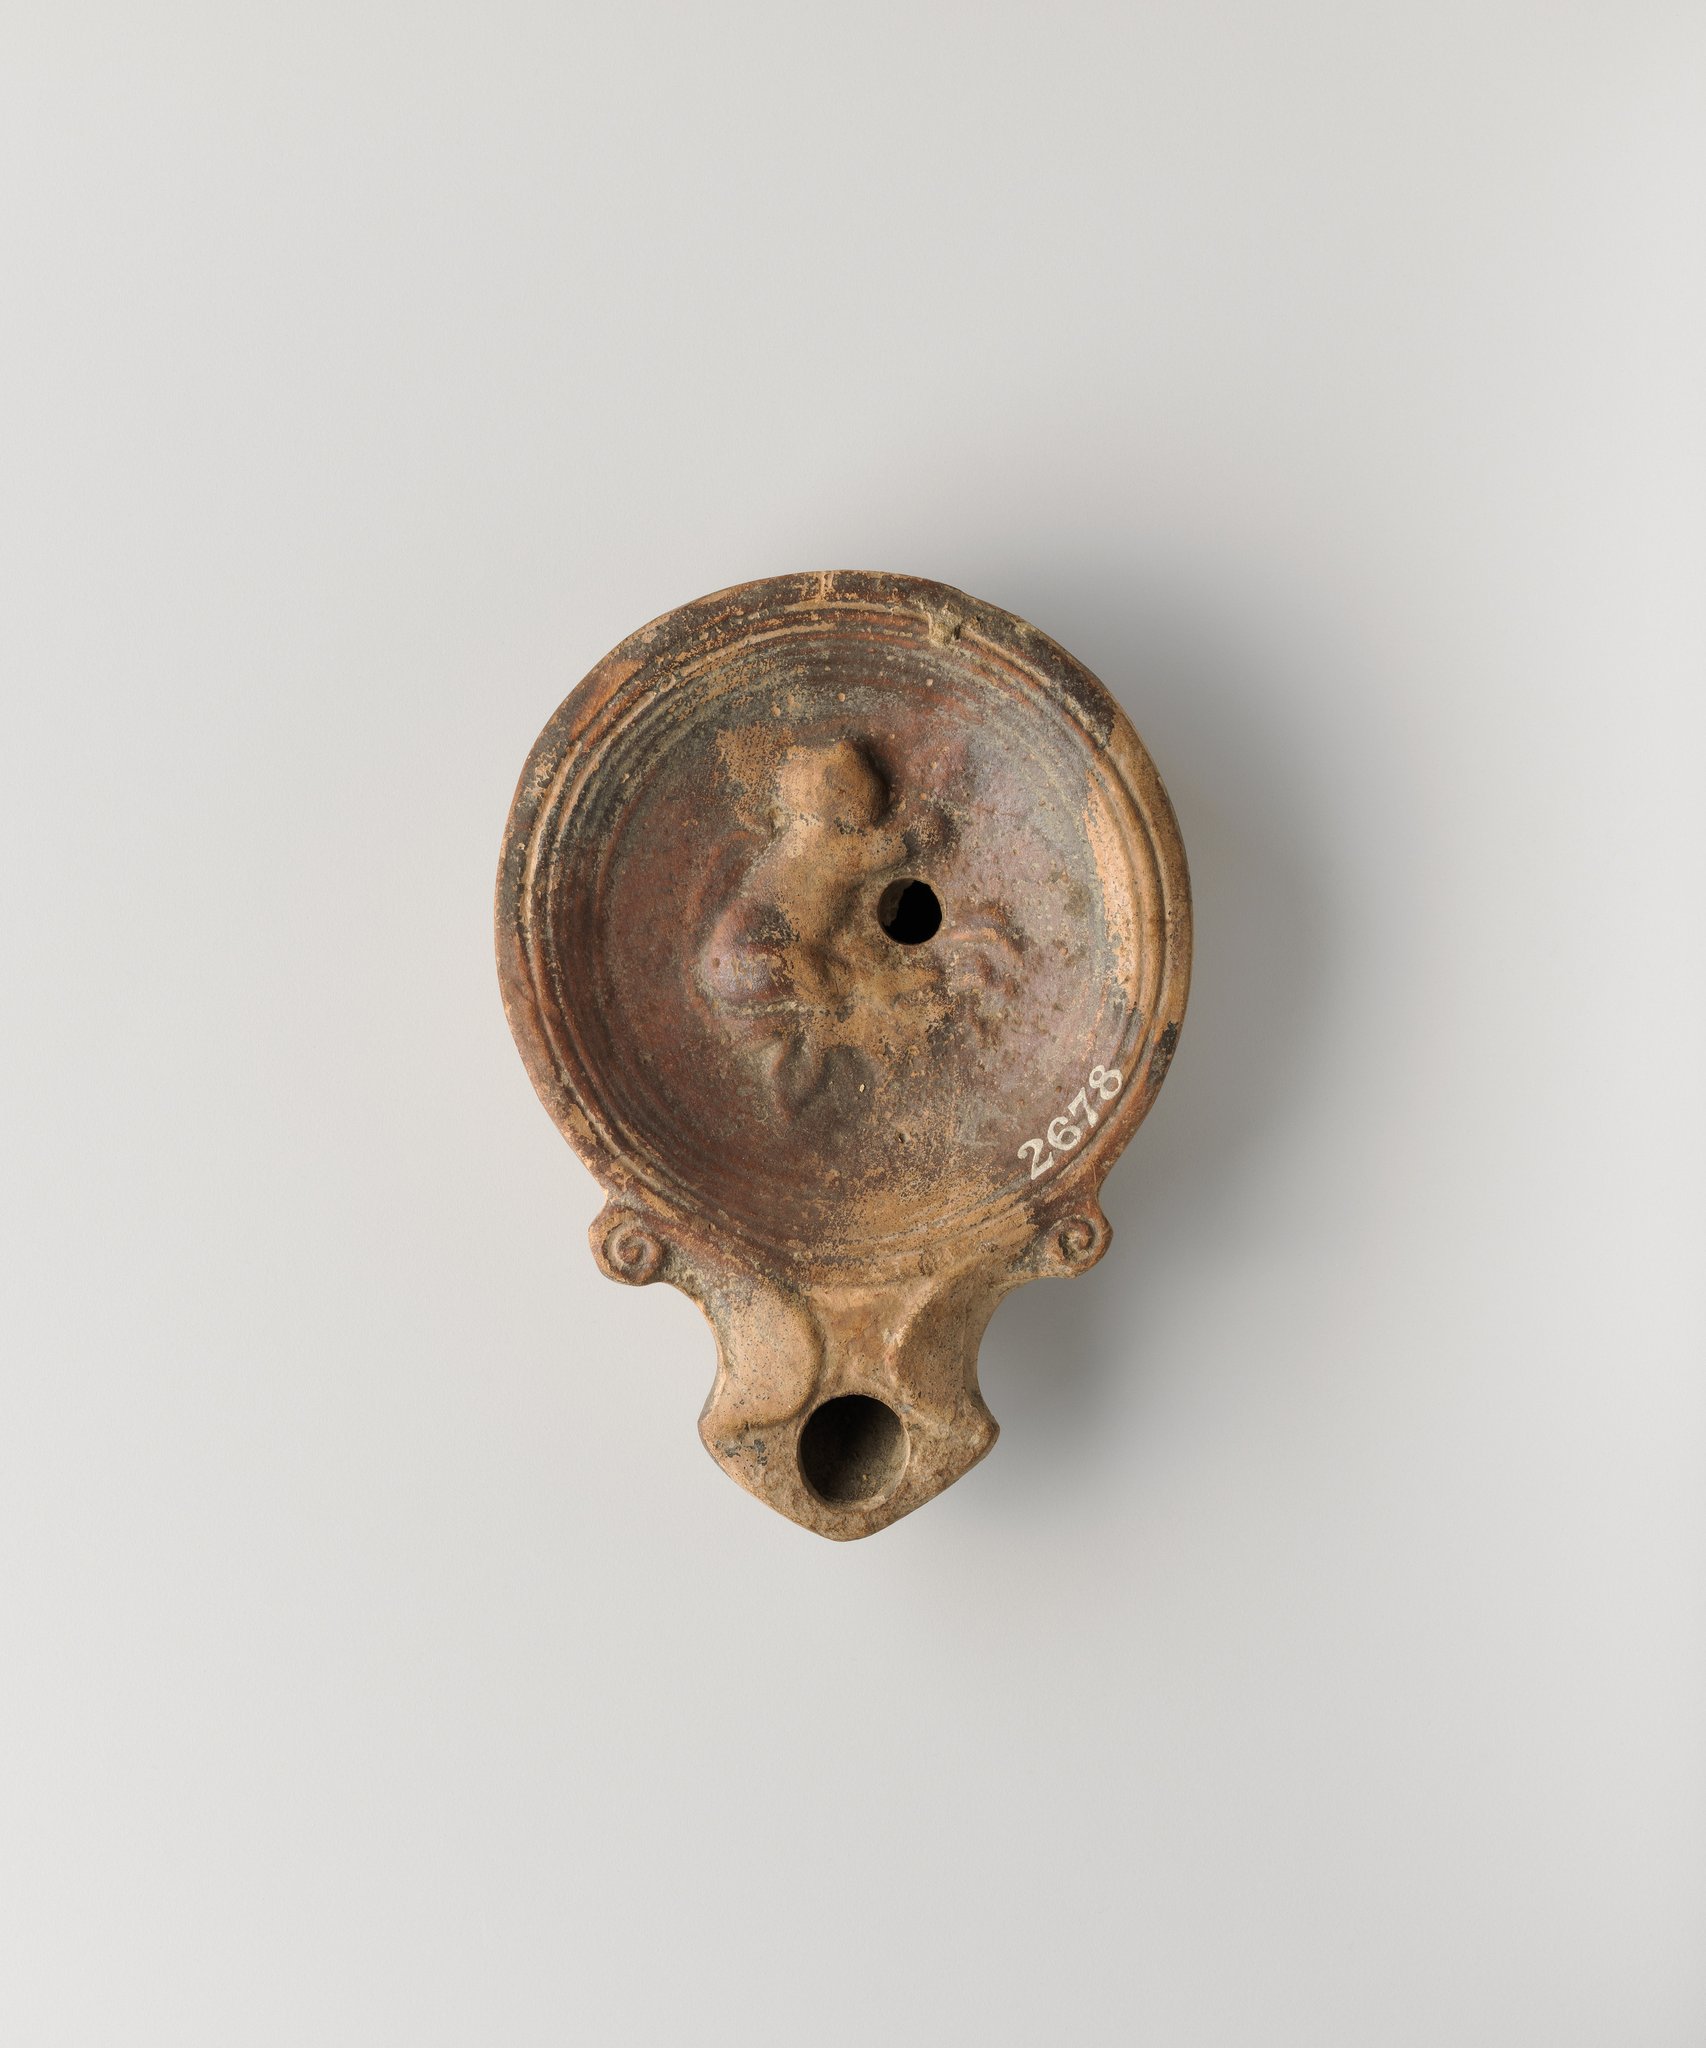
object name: lamp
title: Terracotta oil lamp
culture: roman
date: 100 BCE-100 CE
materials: terracotta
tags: eros